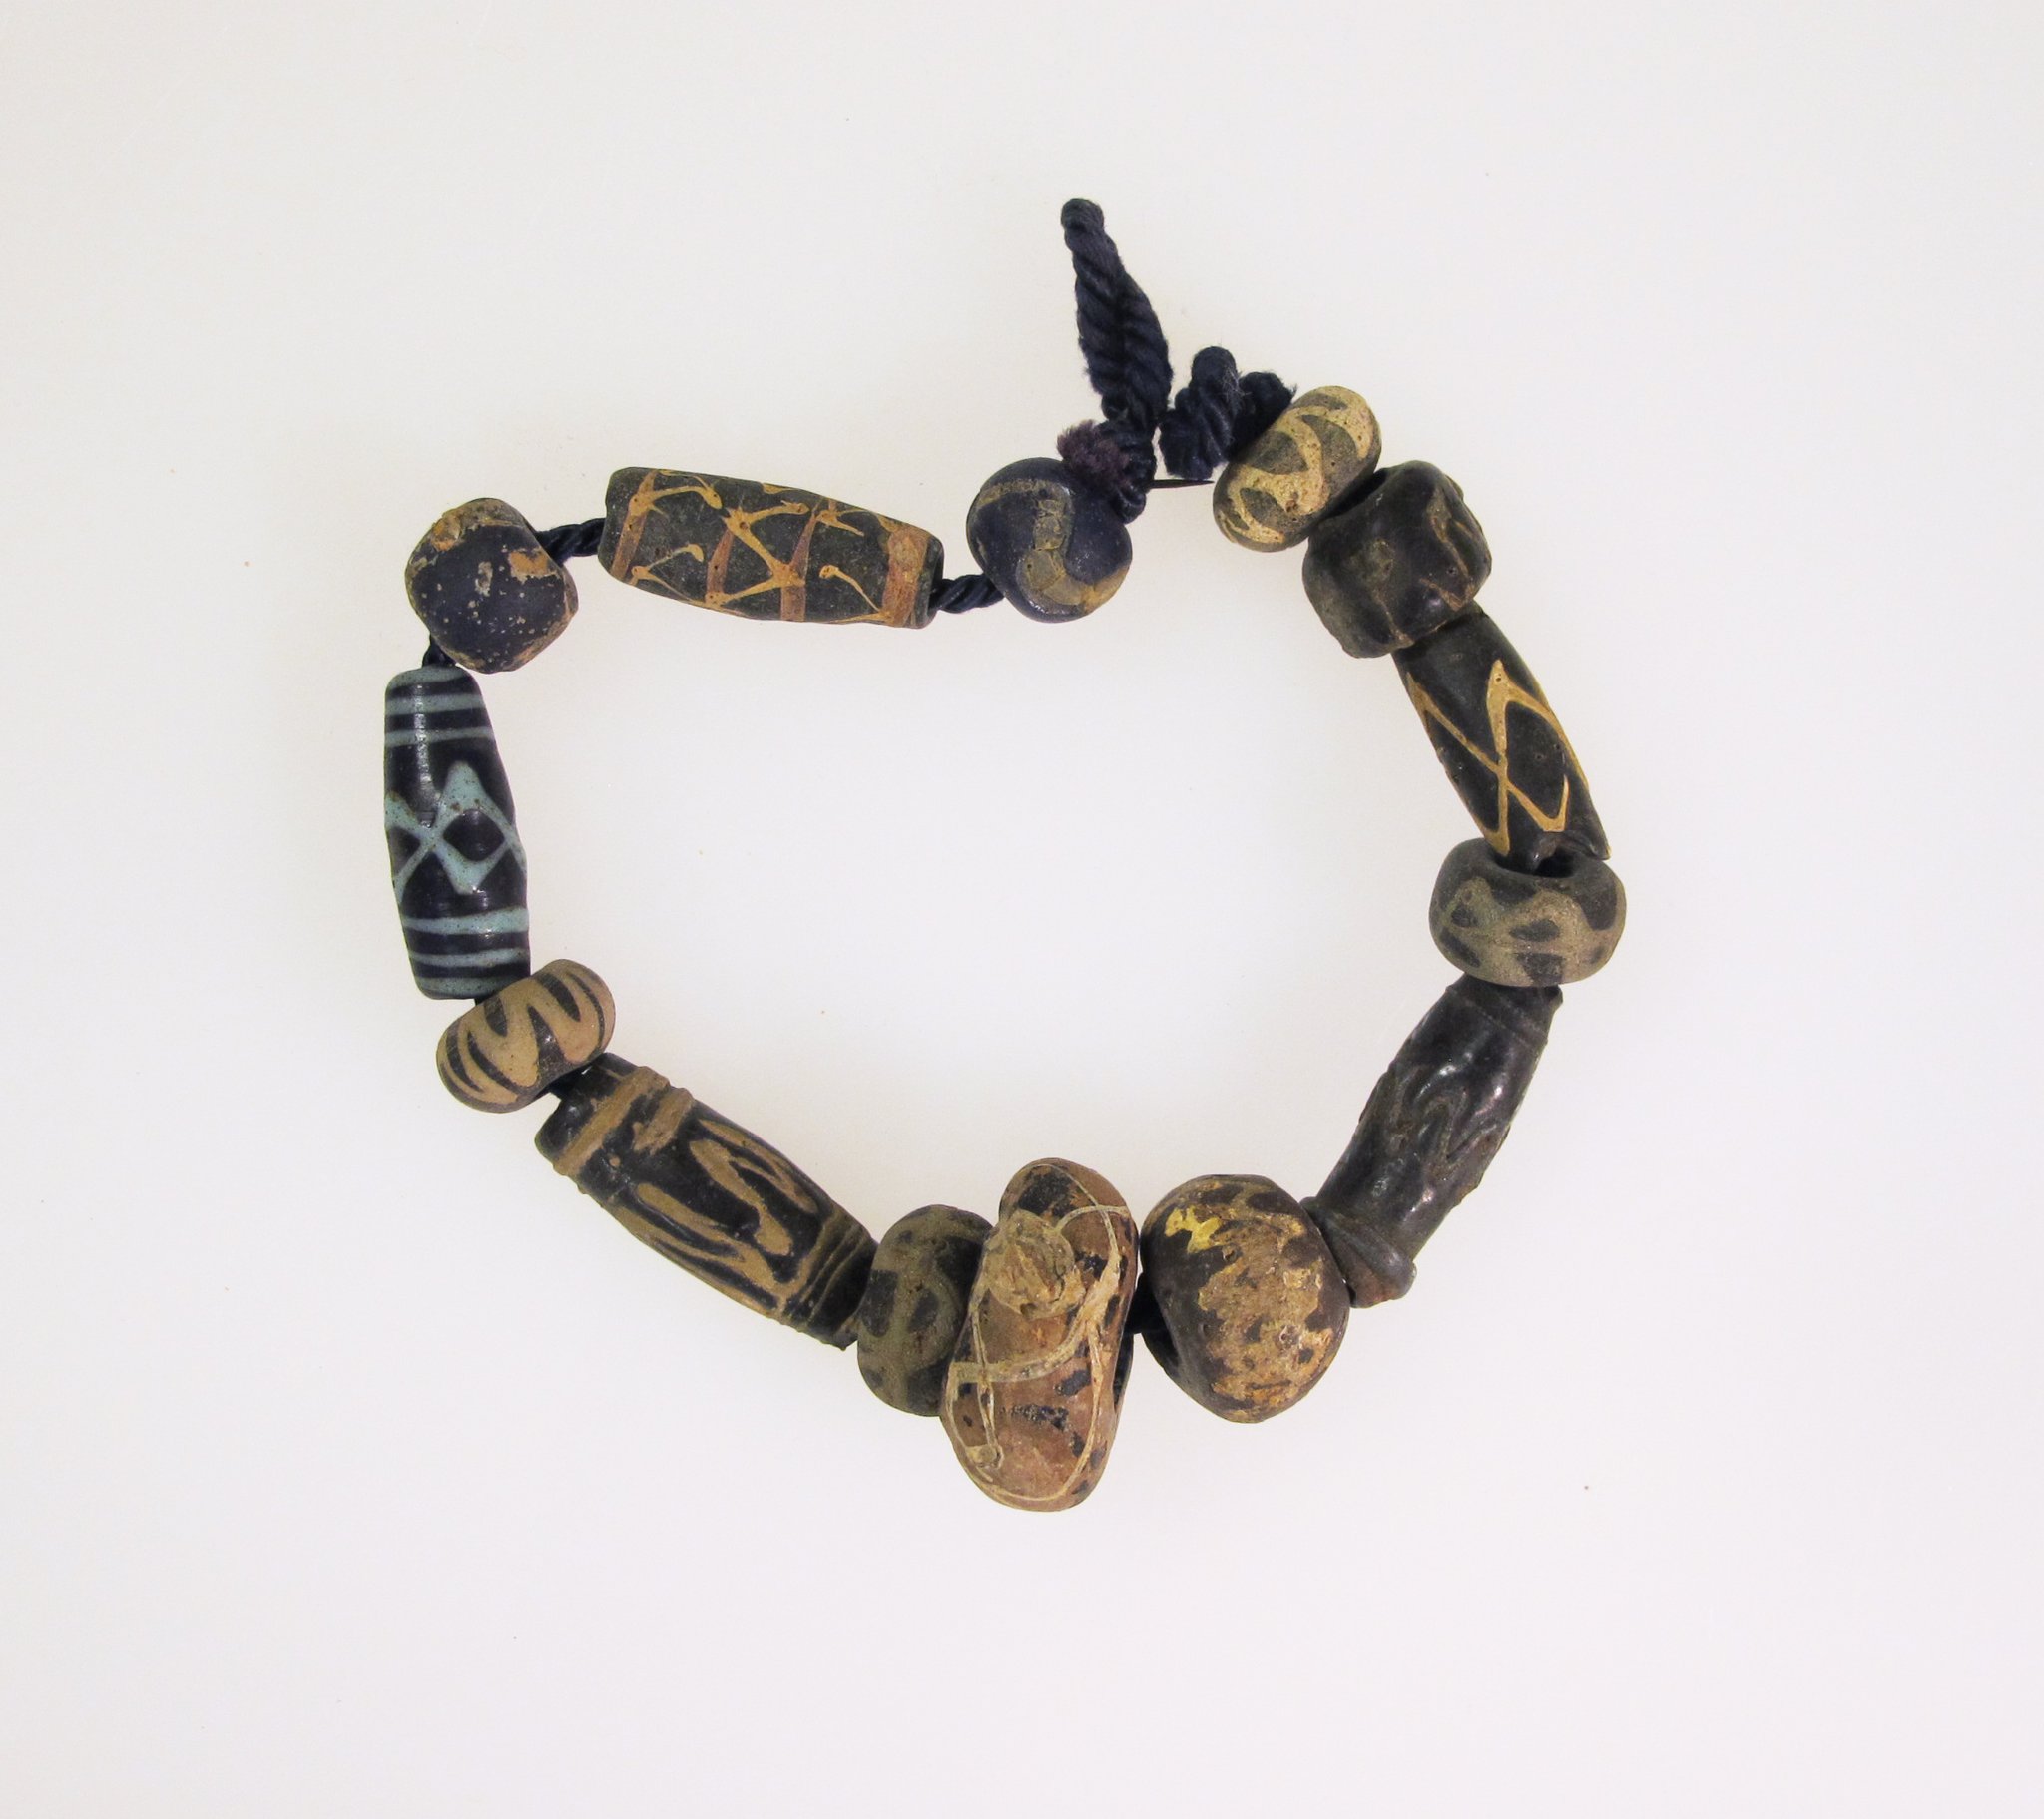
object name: bead, 14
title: Beads, 14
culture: roman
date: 670 BCE-330 CE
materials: glass